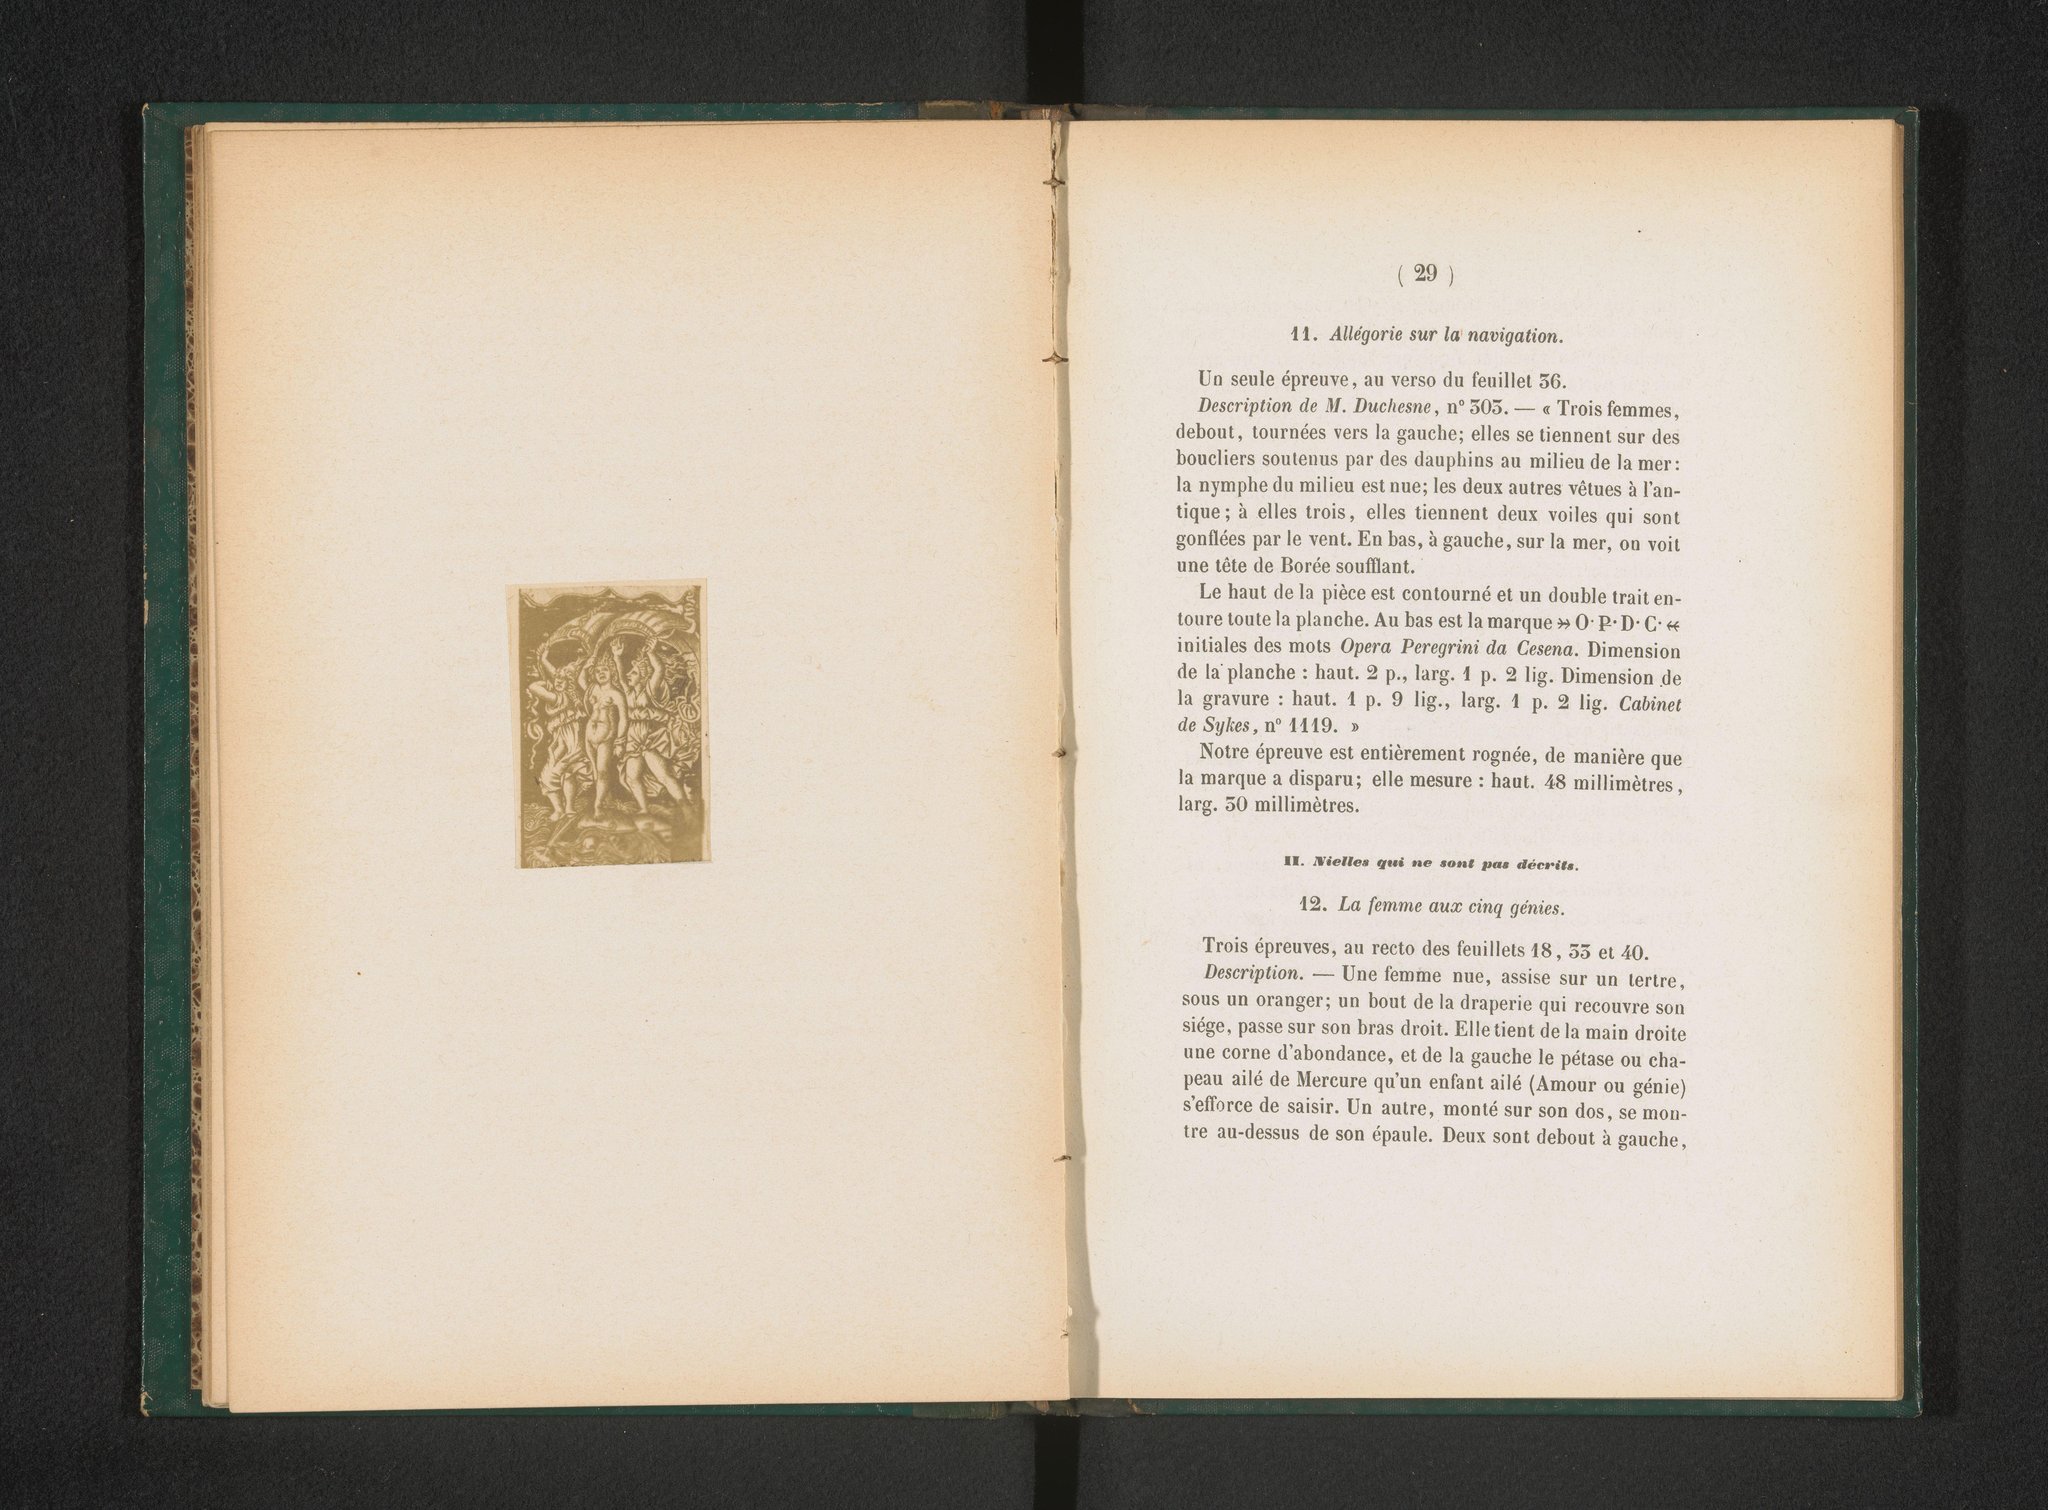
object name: photograph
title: Fotoreproductie van een prent van een allegorie op de navigatie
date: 1852-1857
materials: photographic support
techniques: salted paper print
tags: signalling ~ navigation, symbolic representations, allegories and emblems ~ drawing